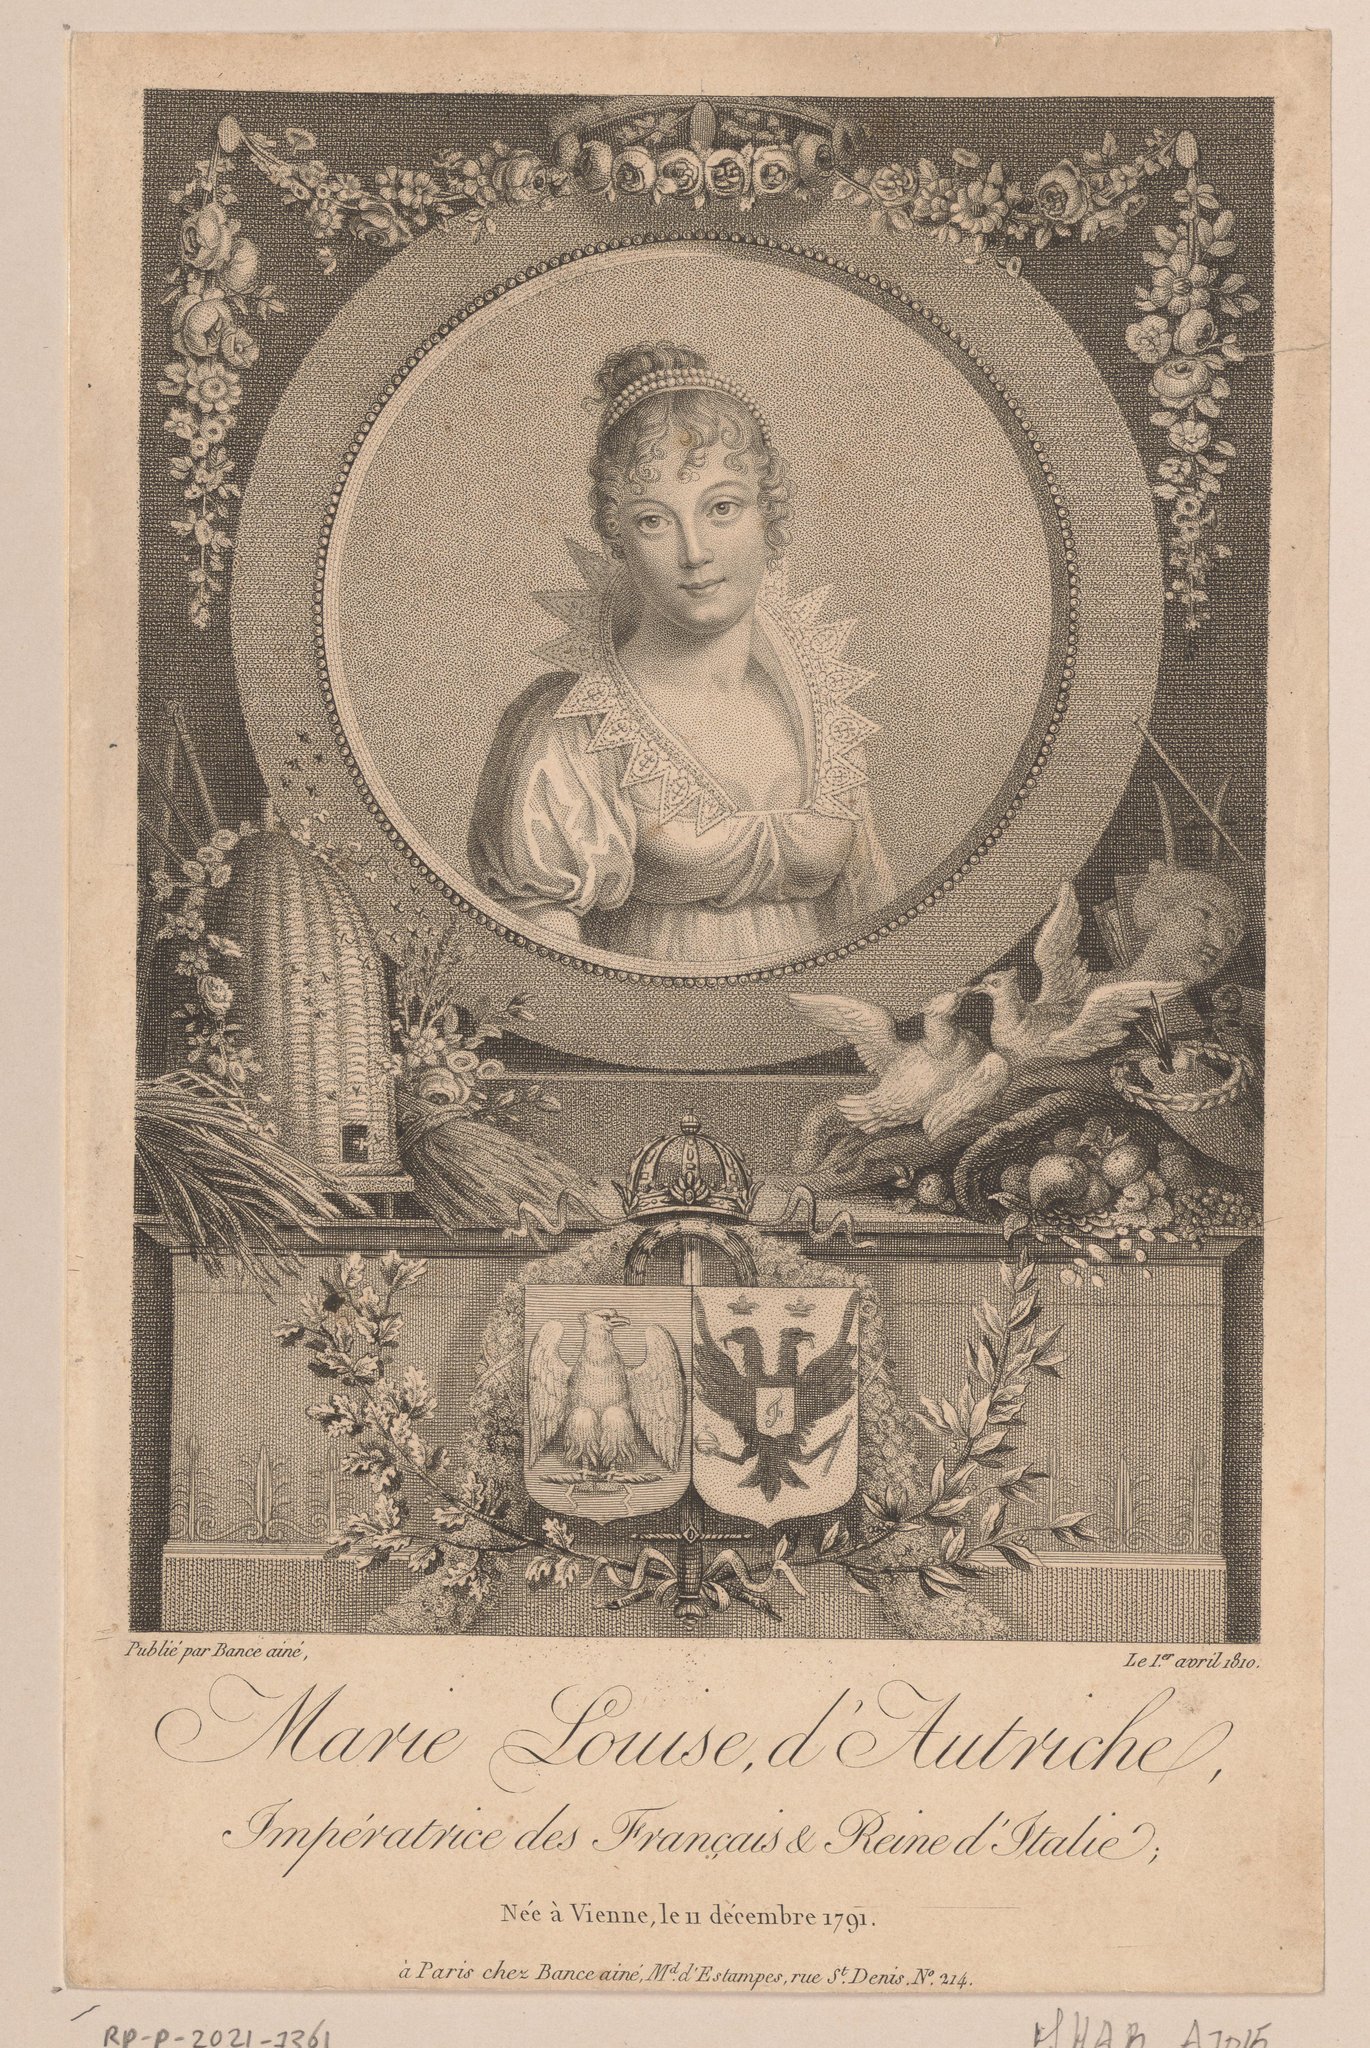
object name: print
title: Portret van Marie Louise van Oostenrijk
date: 1810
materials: paper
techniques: etching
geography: france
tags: vienna, marie louise van oostenrijk (keizerin der fransen), coat of arms (symbol of sovereignty), historical persons - bb - woman, ornament ~ medallion, queen, empress, etc. (wife of a ruler), bee-hive, crown (symbol of sovereignty) - bb - female ruler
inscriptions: date